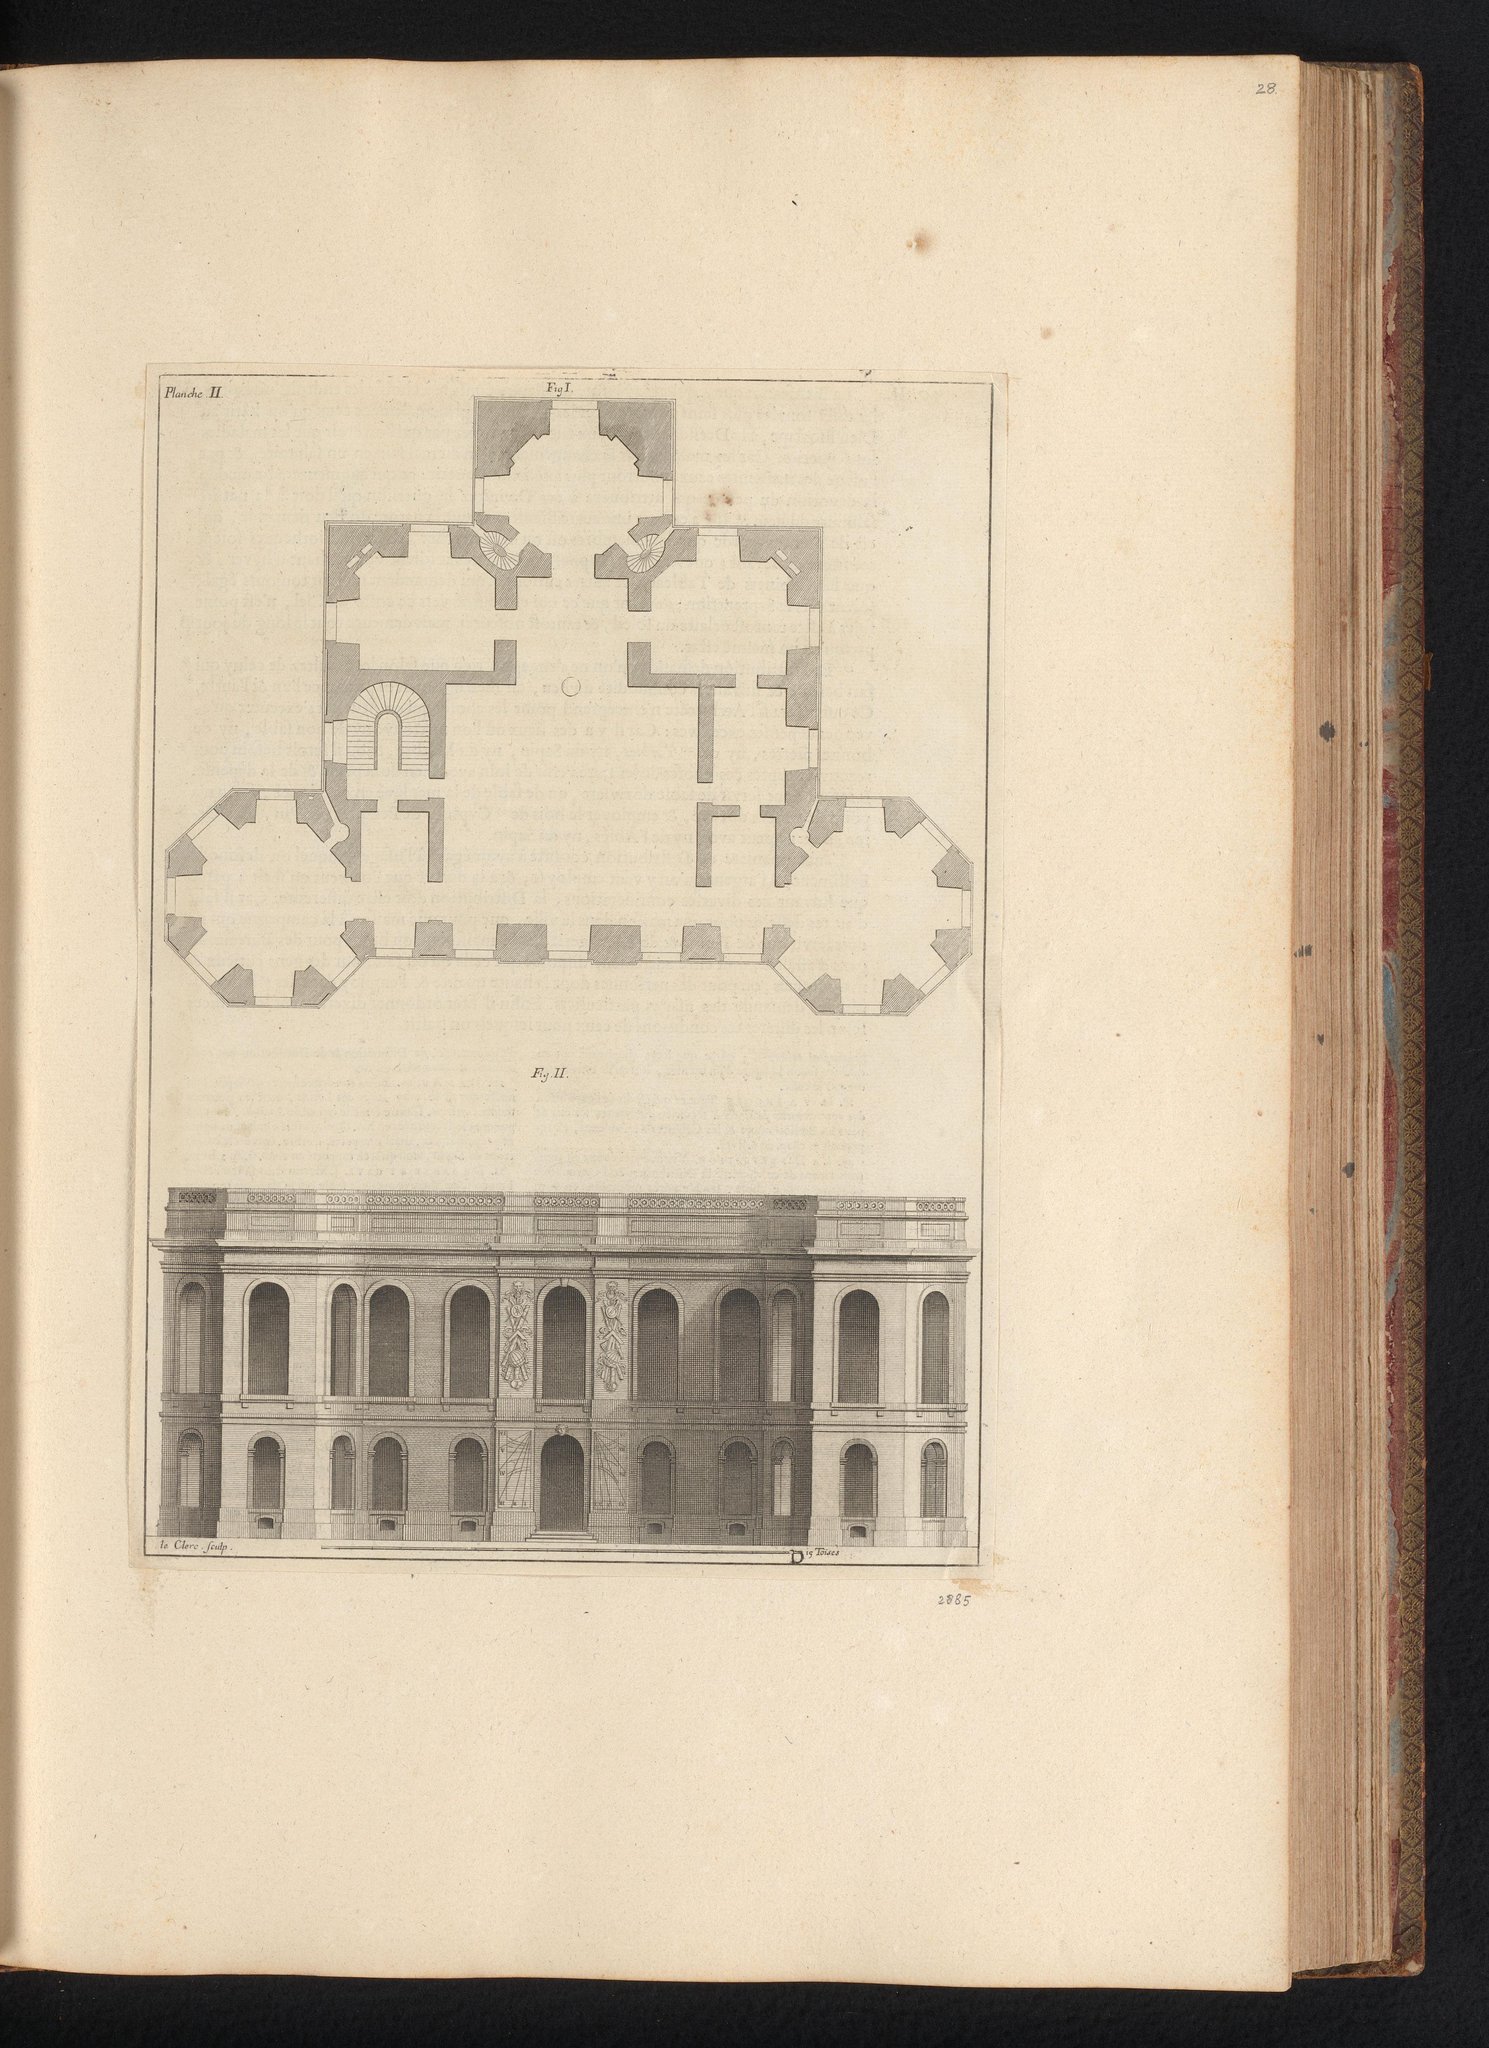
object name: book illustration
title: Planche II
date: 1673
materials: paper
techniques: engraving, etching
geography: paris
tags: observatory (~ astronomy), architecture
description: Prent uit: Perrault, Claude. Les dix livres d'architecture de Vitruve. Parijs: Jean-Baptiste Coignard, 1673.